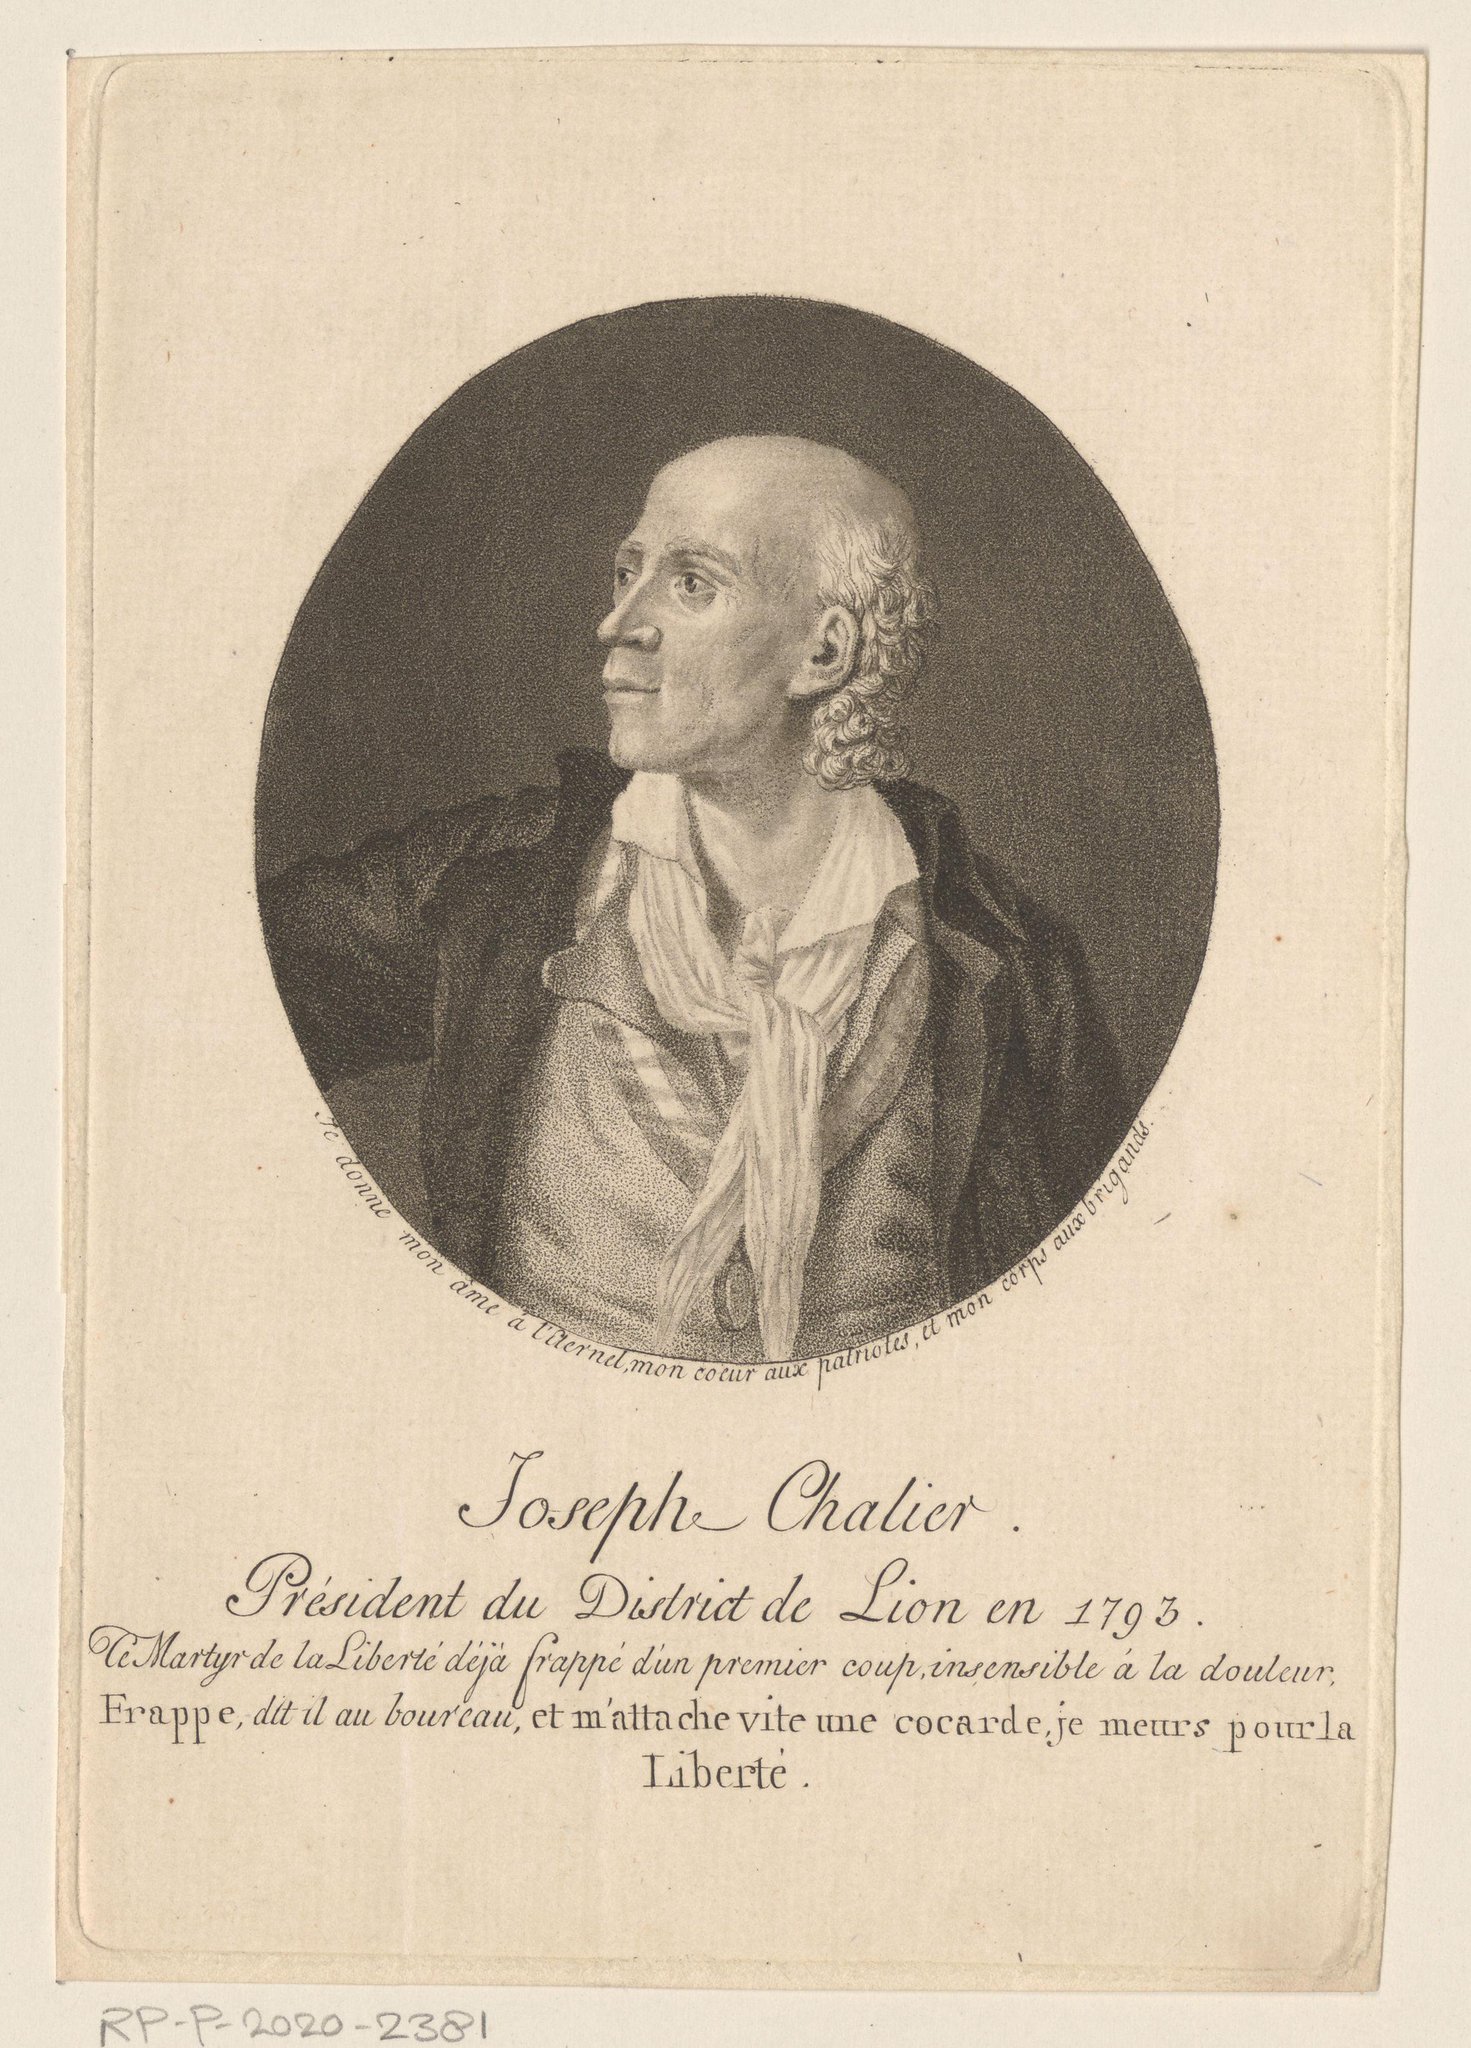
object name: print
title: Portret van Joseph Chalier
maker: Anonymous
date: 1793-1810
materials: paper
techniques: stippling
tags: politician, historical persons